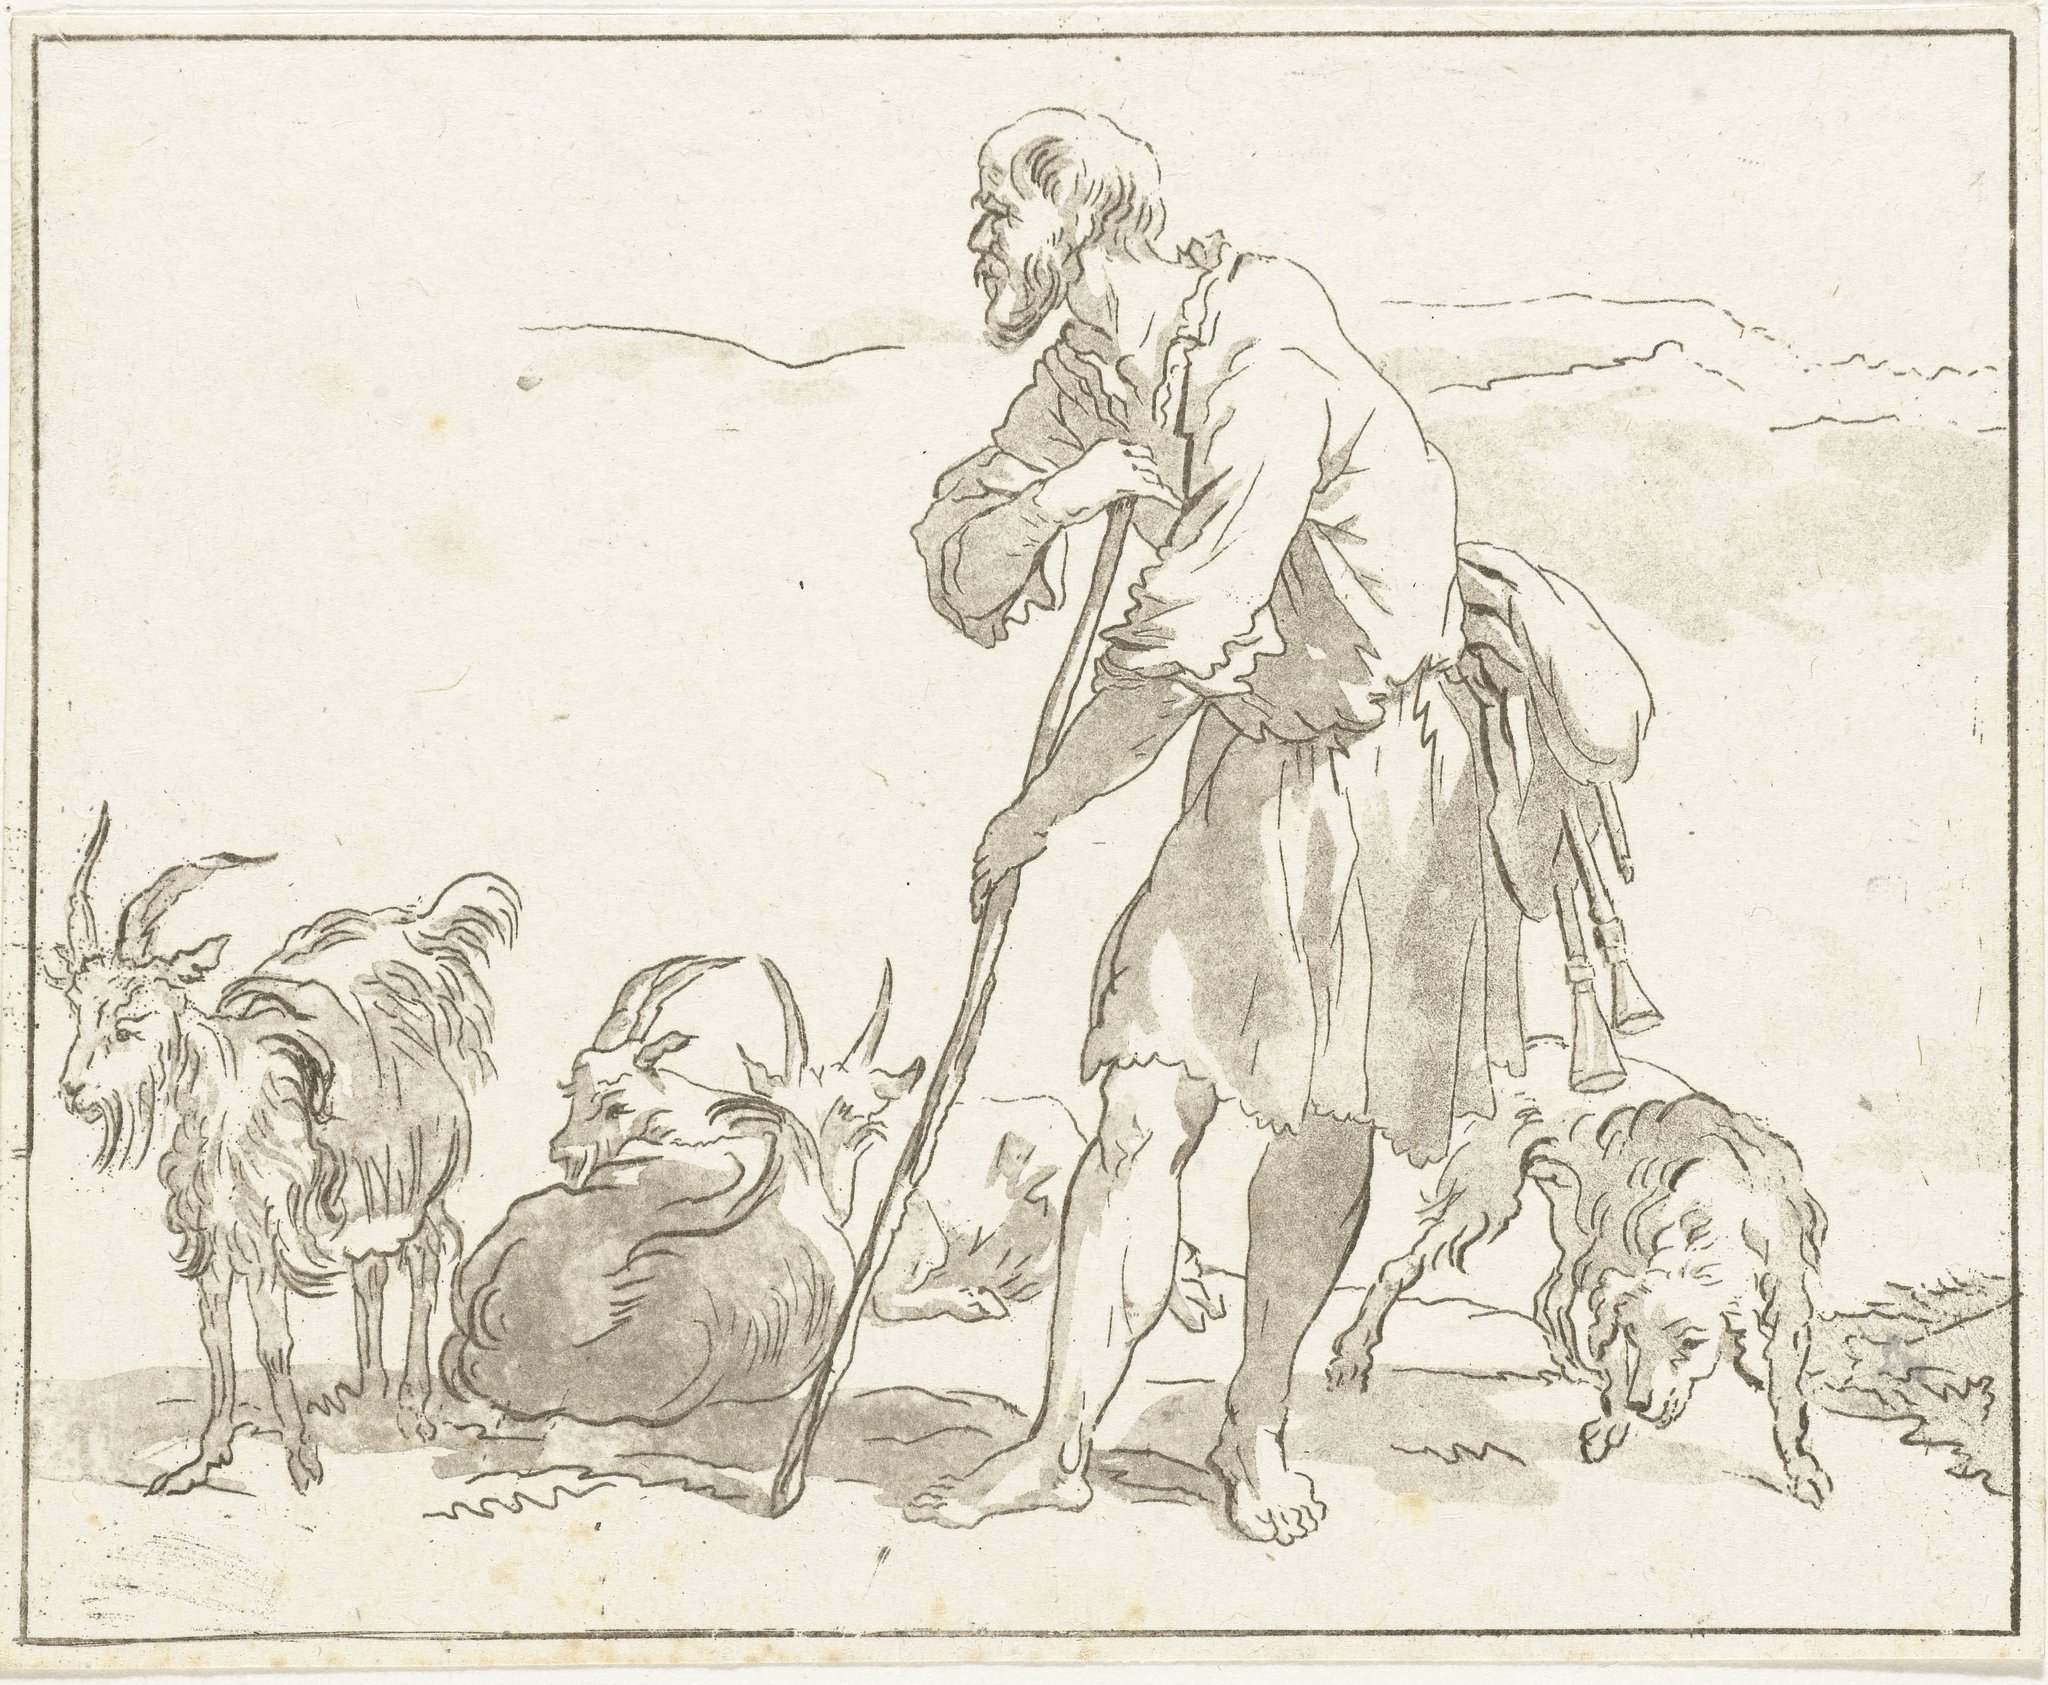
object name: print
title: Herder met geiten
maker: anthonie van den bos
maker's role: draughtsman, print maker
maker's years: 1763-1838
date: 1778-1838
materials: paper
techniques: printmaking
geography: netherlands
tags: herding, herdsman, herdswoman, shepherd, shepherdess, cowherd, etc., bagpipe, musette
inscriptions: collector's mark: Lugt 2228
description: Herder leunend op een stok, met drie geiten en een herdershond. Op zijn rug draagt de herder een doedelzak.